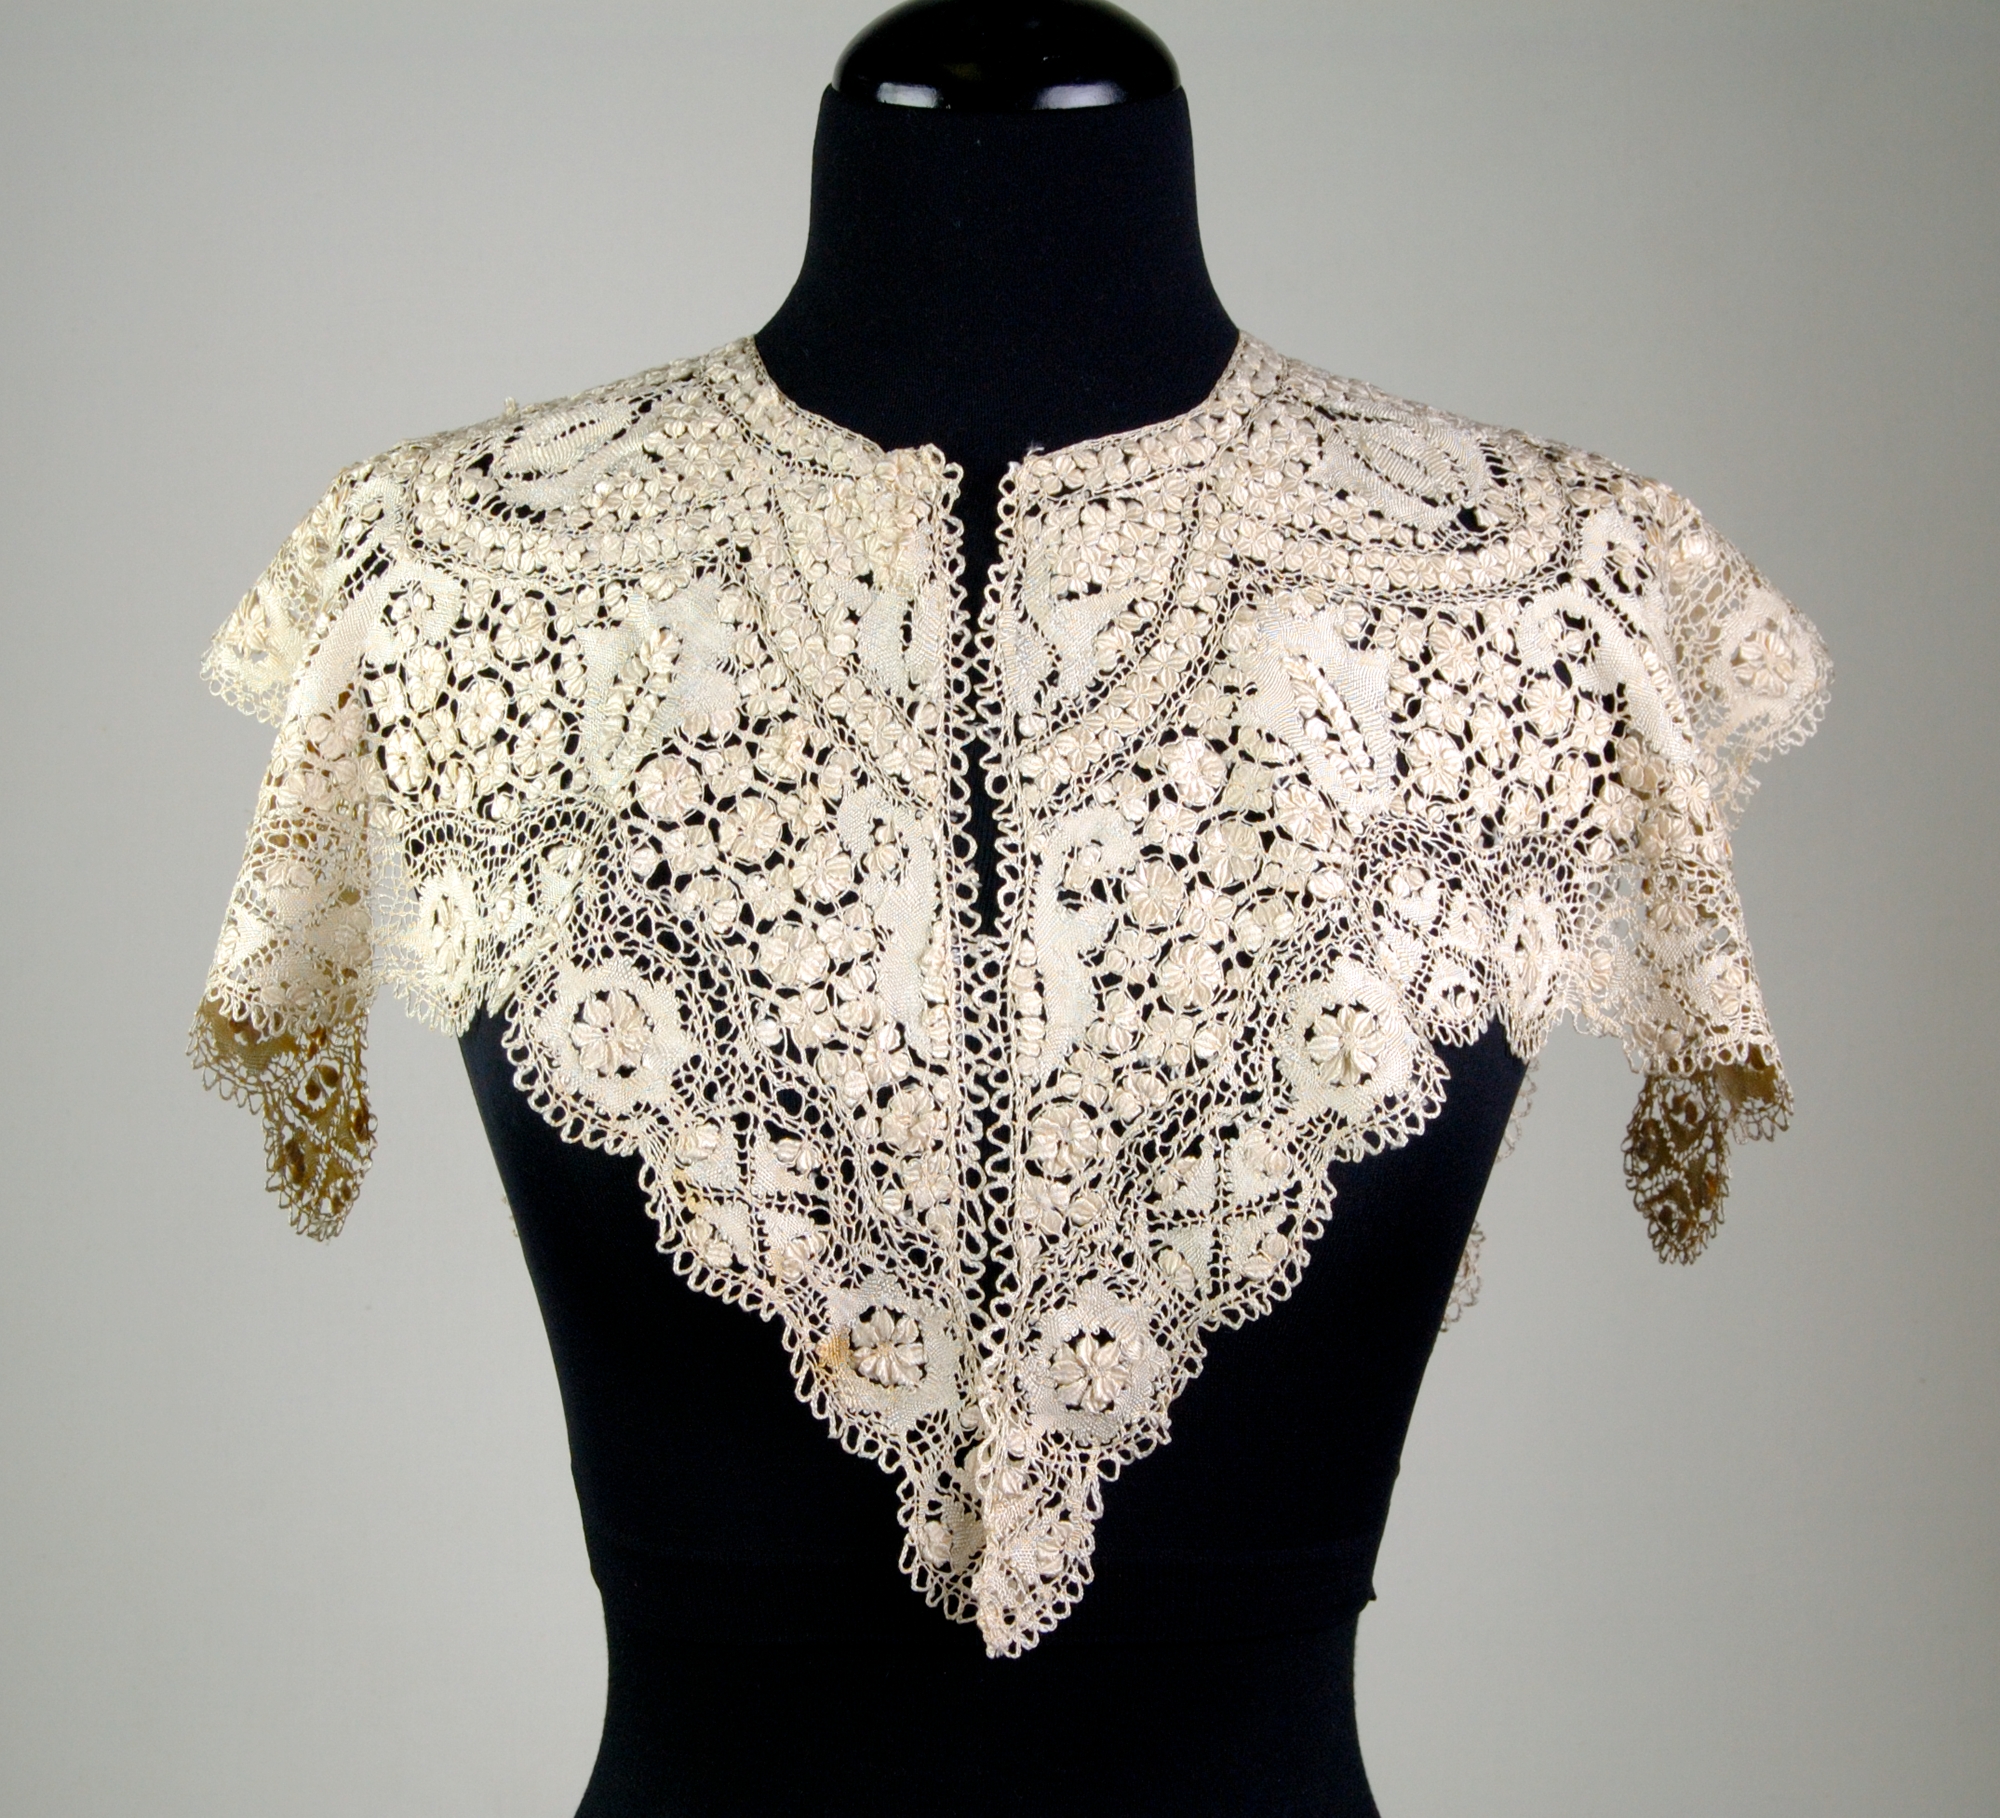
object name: collar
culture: maltese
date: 1851-1875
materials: silk